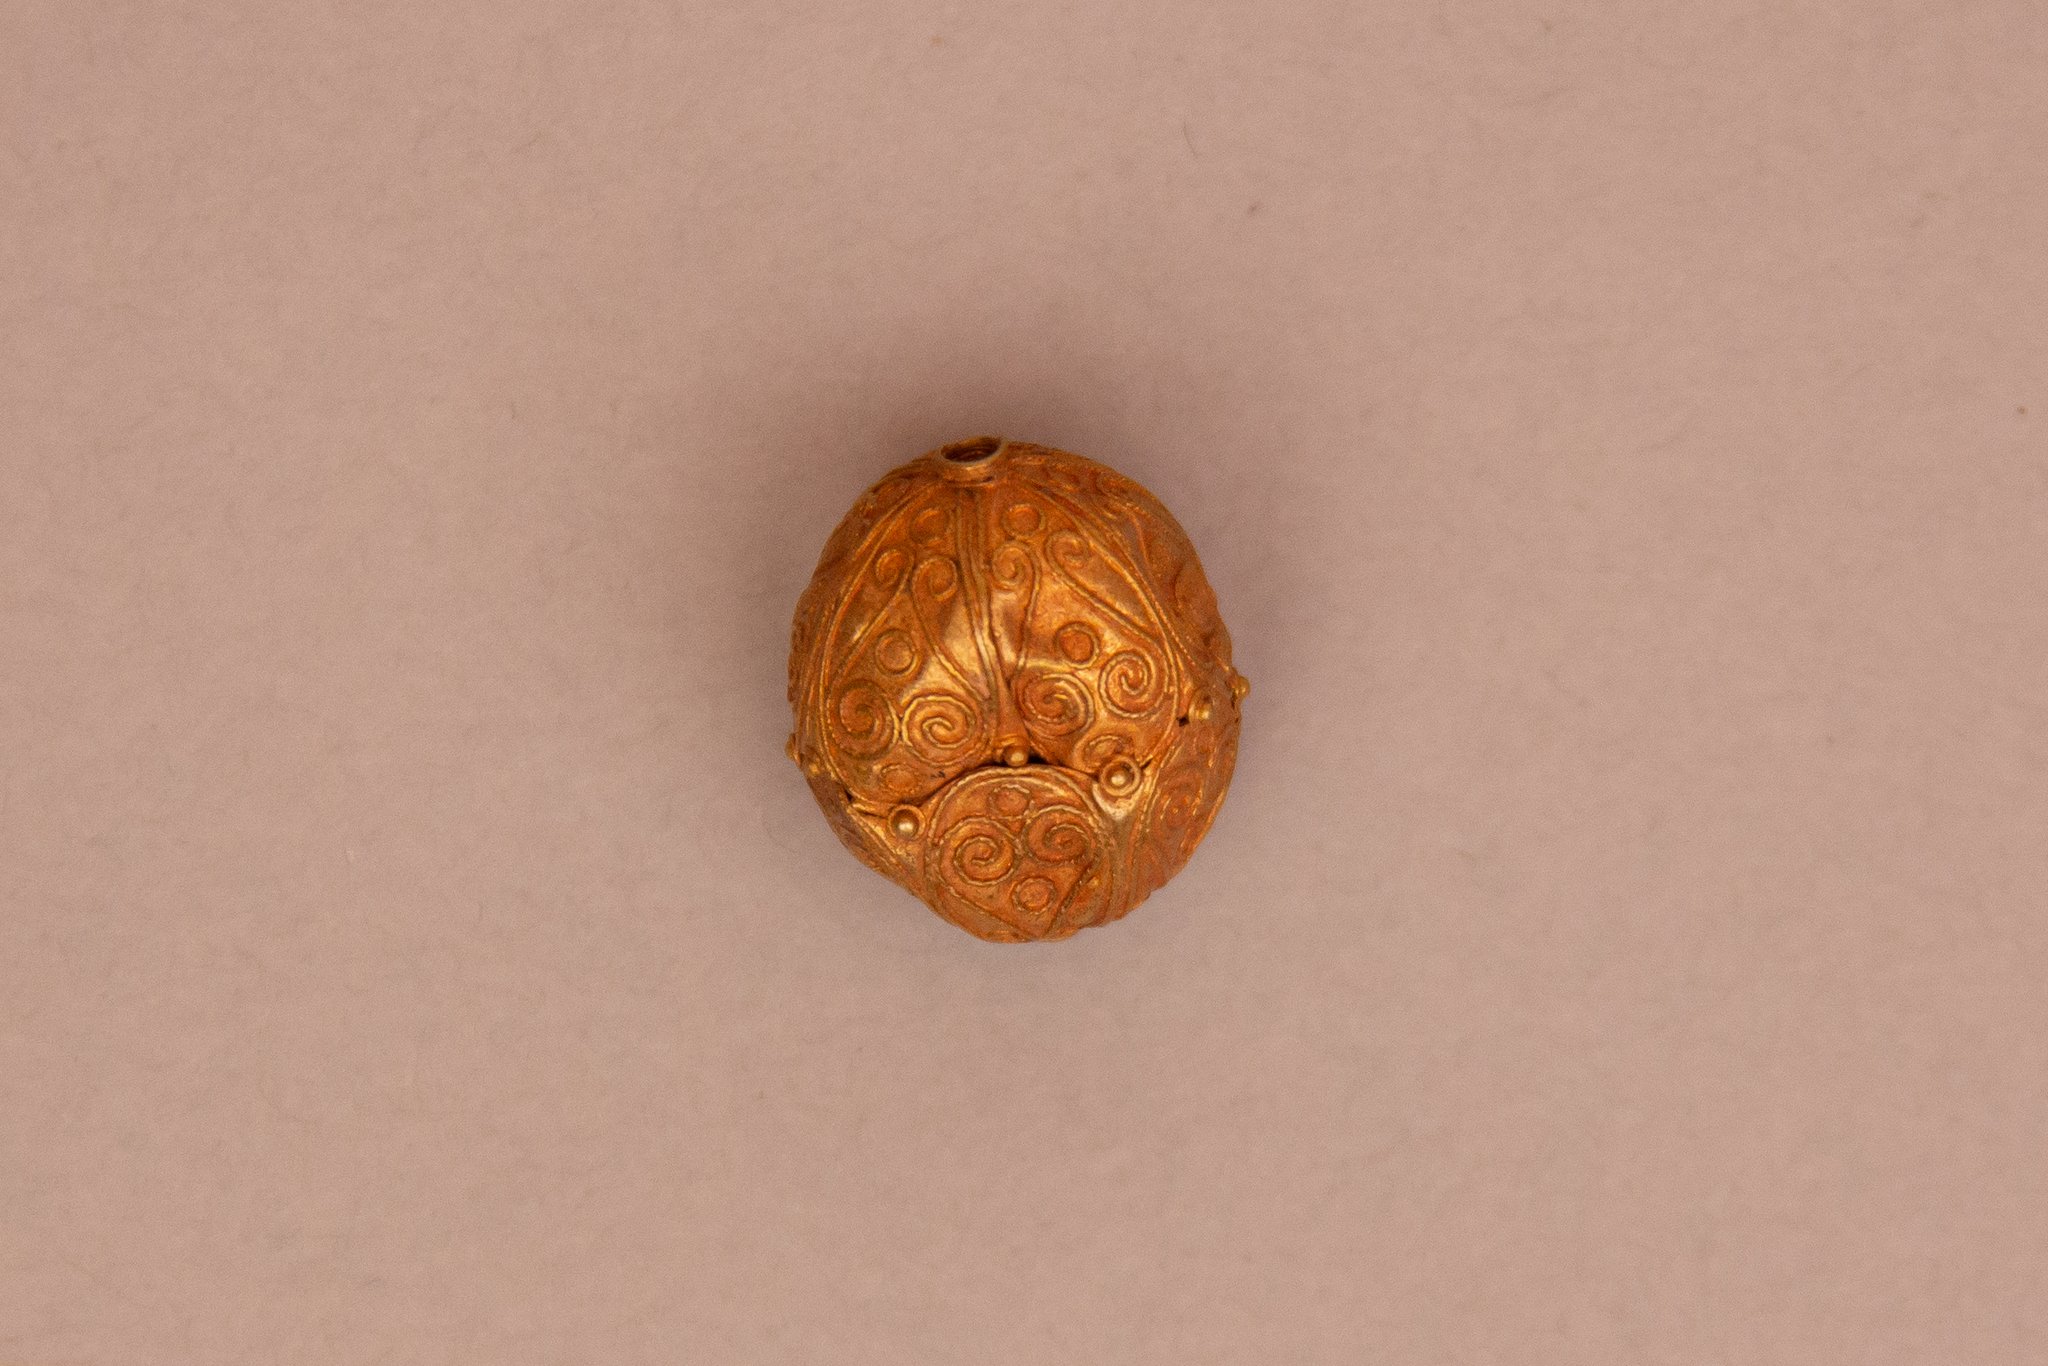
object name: bead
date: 1001-1100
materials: gold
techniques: filigree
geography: egypt or syria